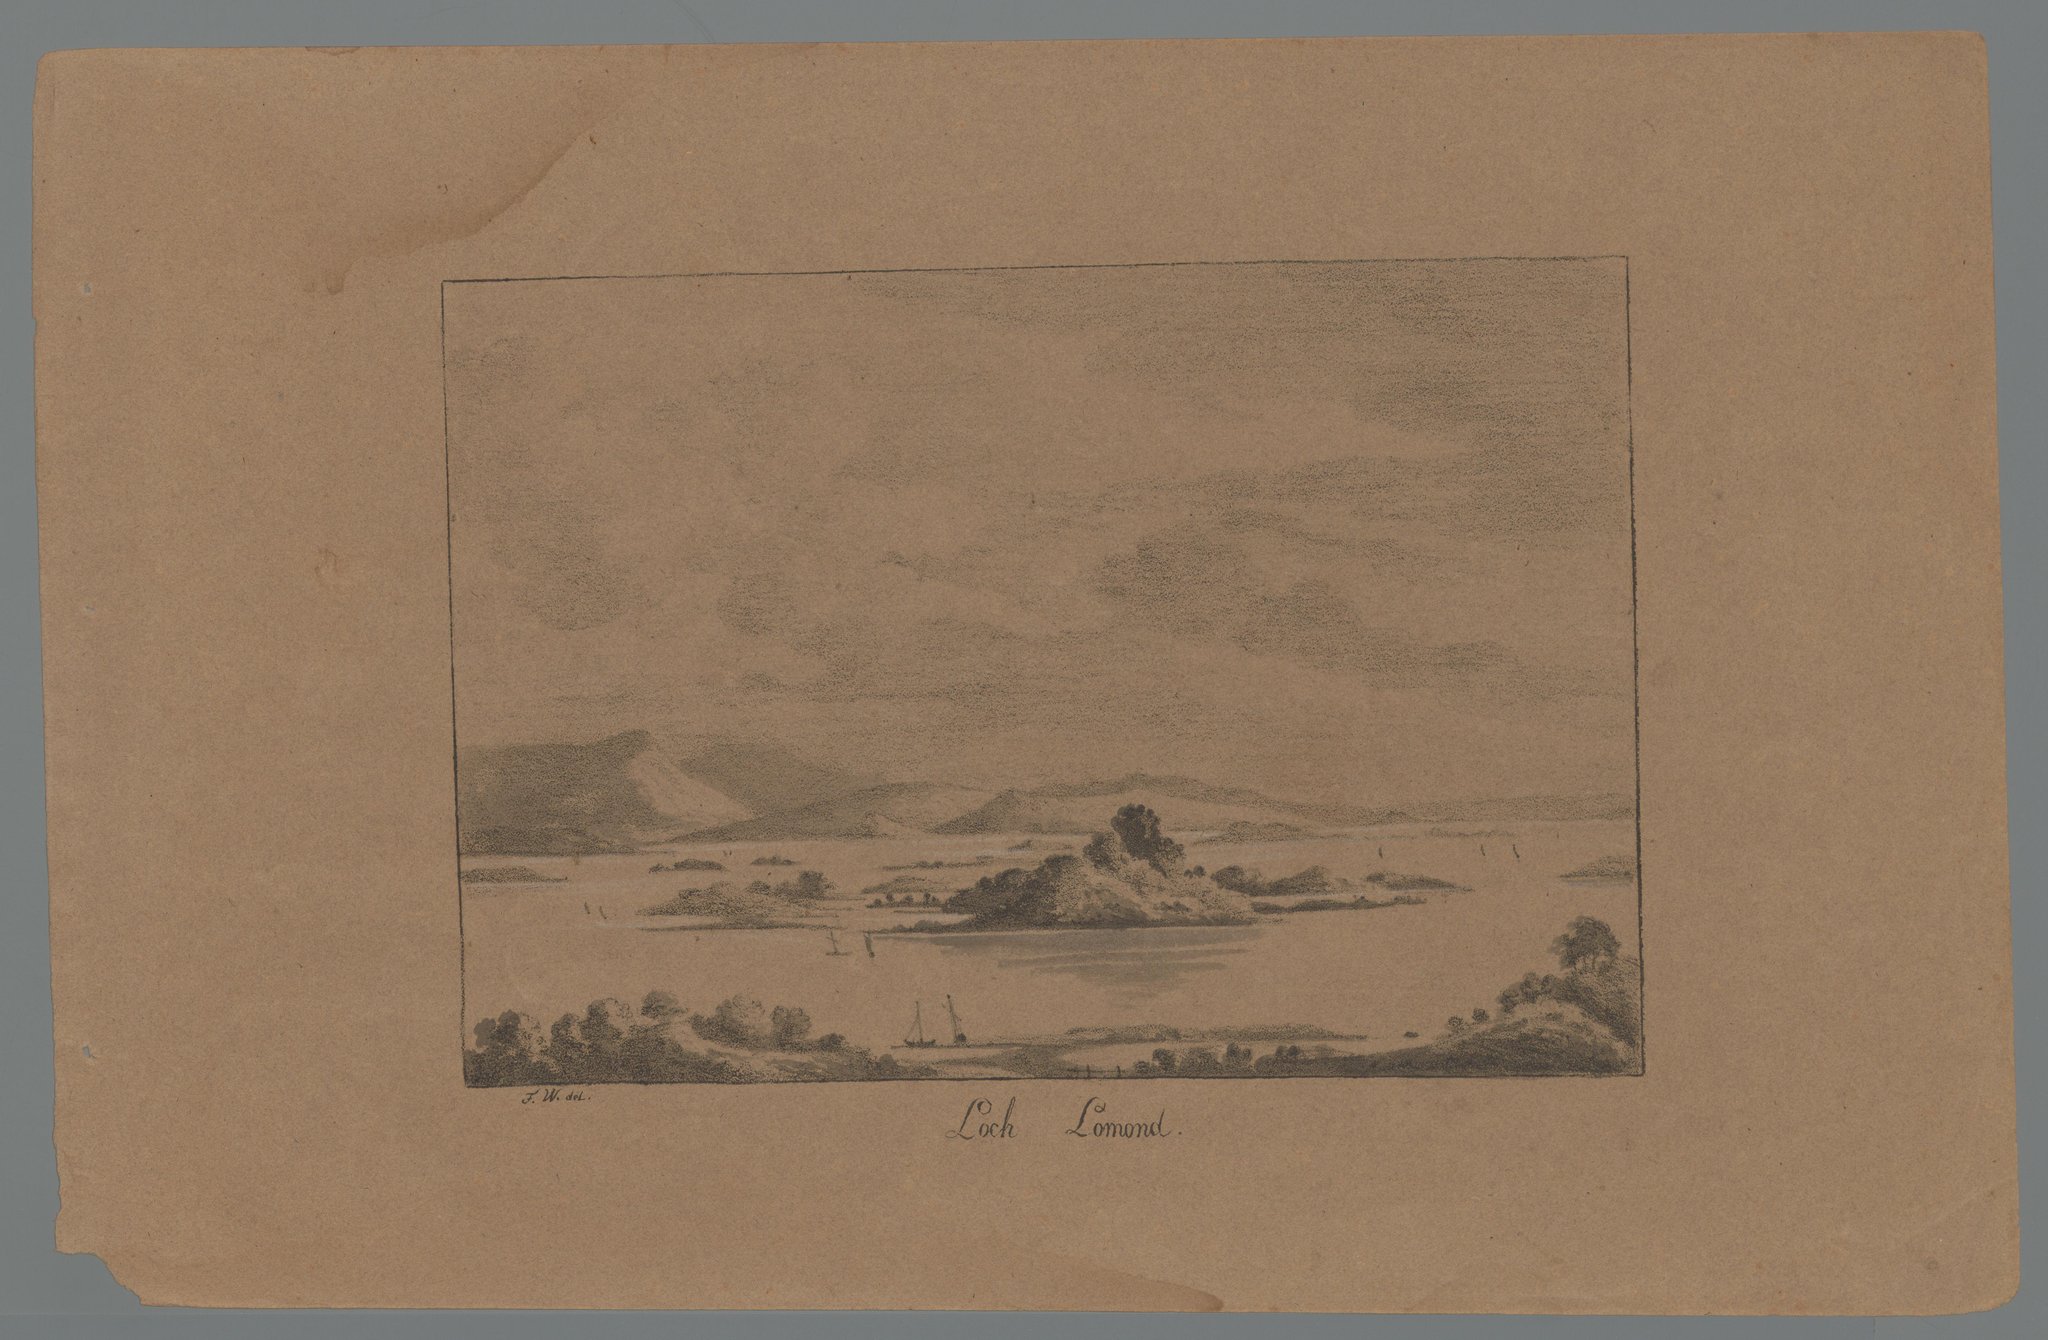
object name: print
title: Twaalf gezichten op Schotland door Frances Waring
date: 1803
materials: chalk, ink, paper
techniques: brush, lithograph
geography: london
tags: lake, landscapes in the temperate zone (+ landscape with figures, staffage)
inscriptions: collector's mark: Lugt 2233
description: Deze prent behoort tot de serie 'Twelve views in Scotland, delineated by a lady in the polyautographic art of drawing on stone'. Deze serie met twaalf lithografieën is een van de vroegste reeksen lithografieën in Groot-Brittannië.